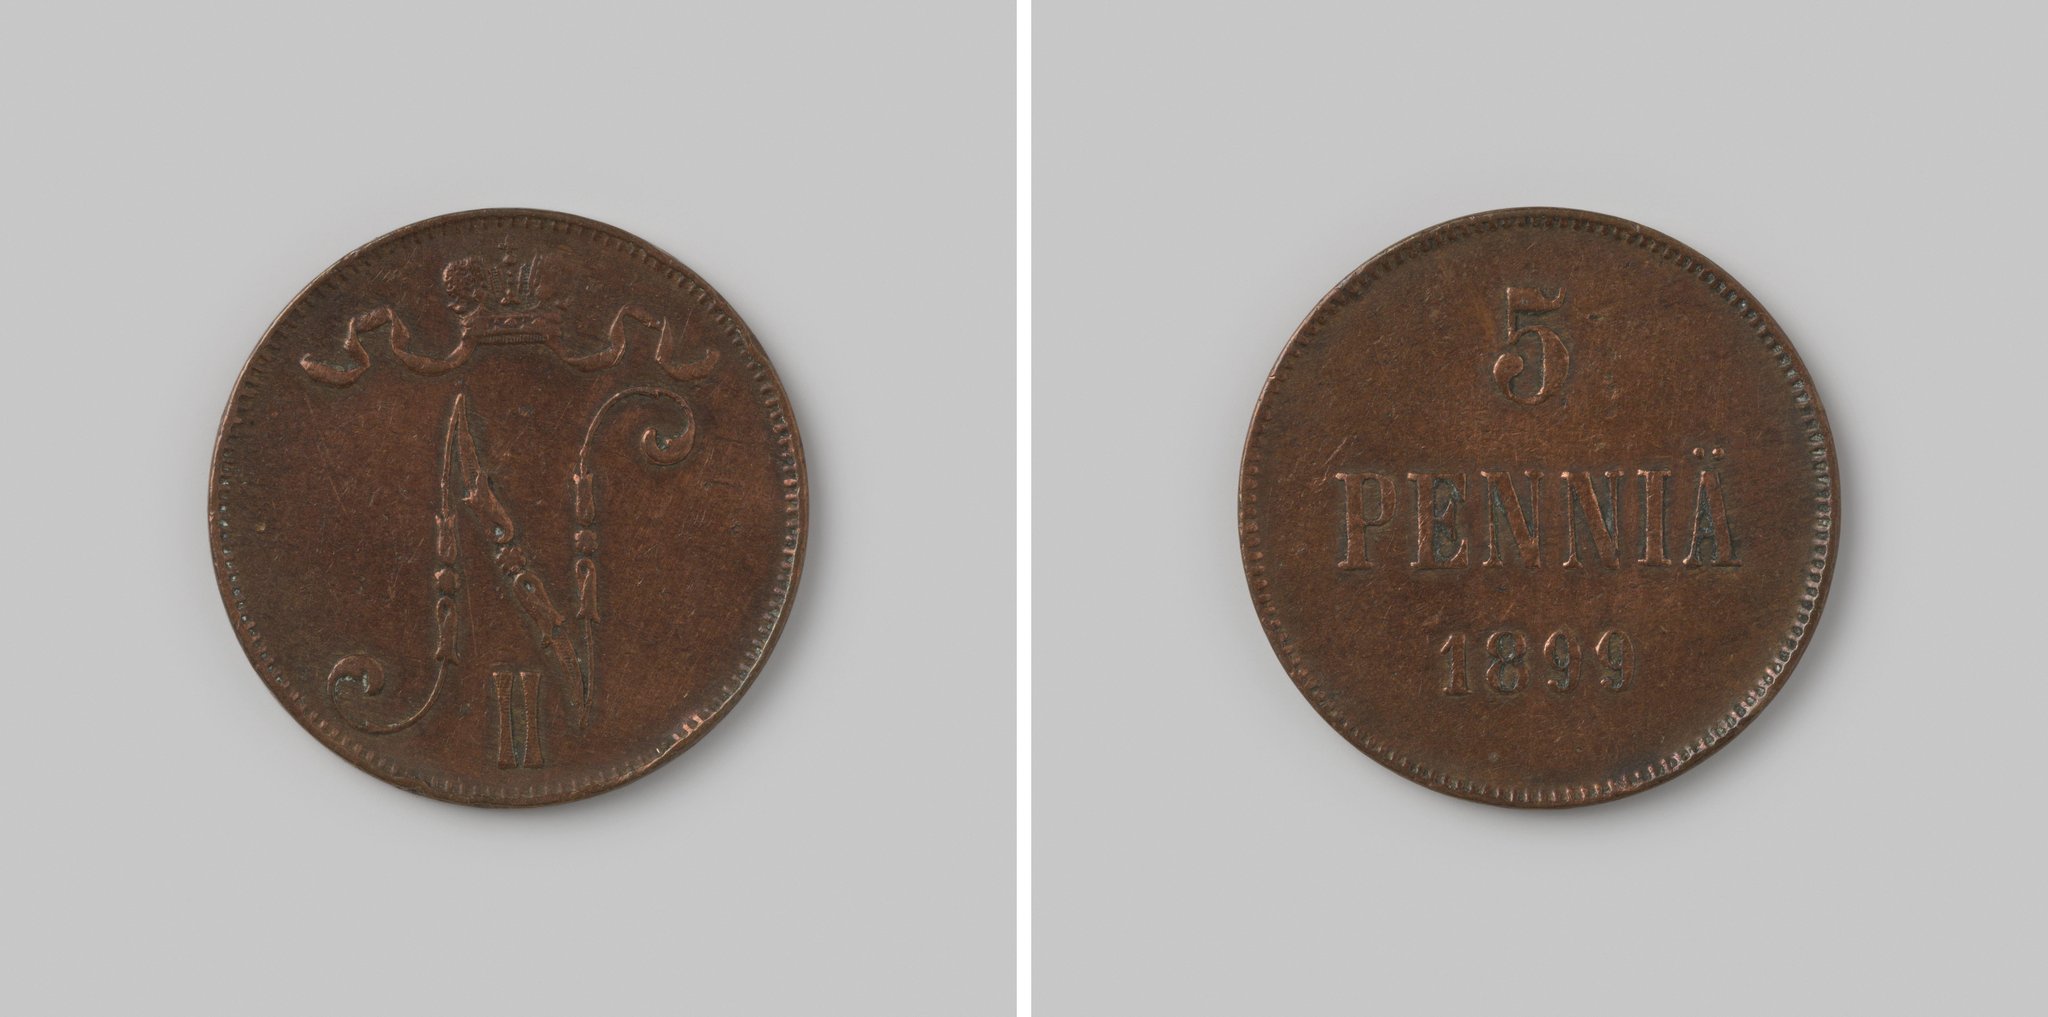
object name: coin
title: 5 penniä uit Finland van tsaar Nicholai II,1899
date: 1899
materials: copper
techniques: striking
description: Koperen munt. Voorzijde: monogram van Nicholai II. Daarboven een kroon met lint. Keerzijde: in twee regels waarde-aanduiding, waaronder jaartal. Gladde rand.